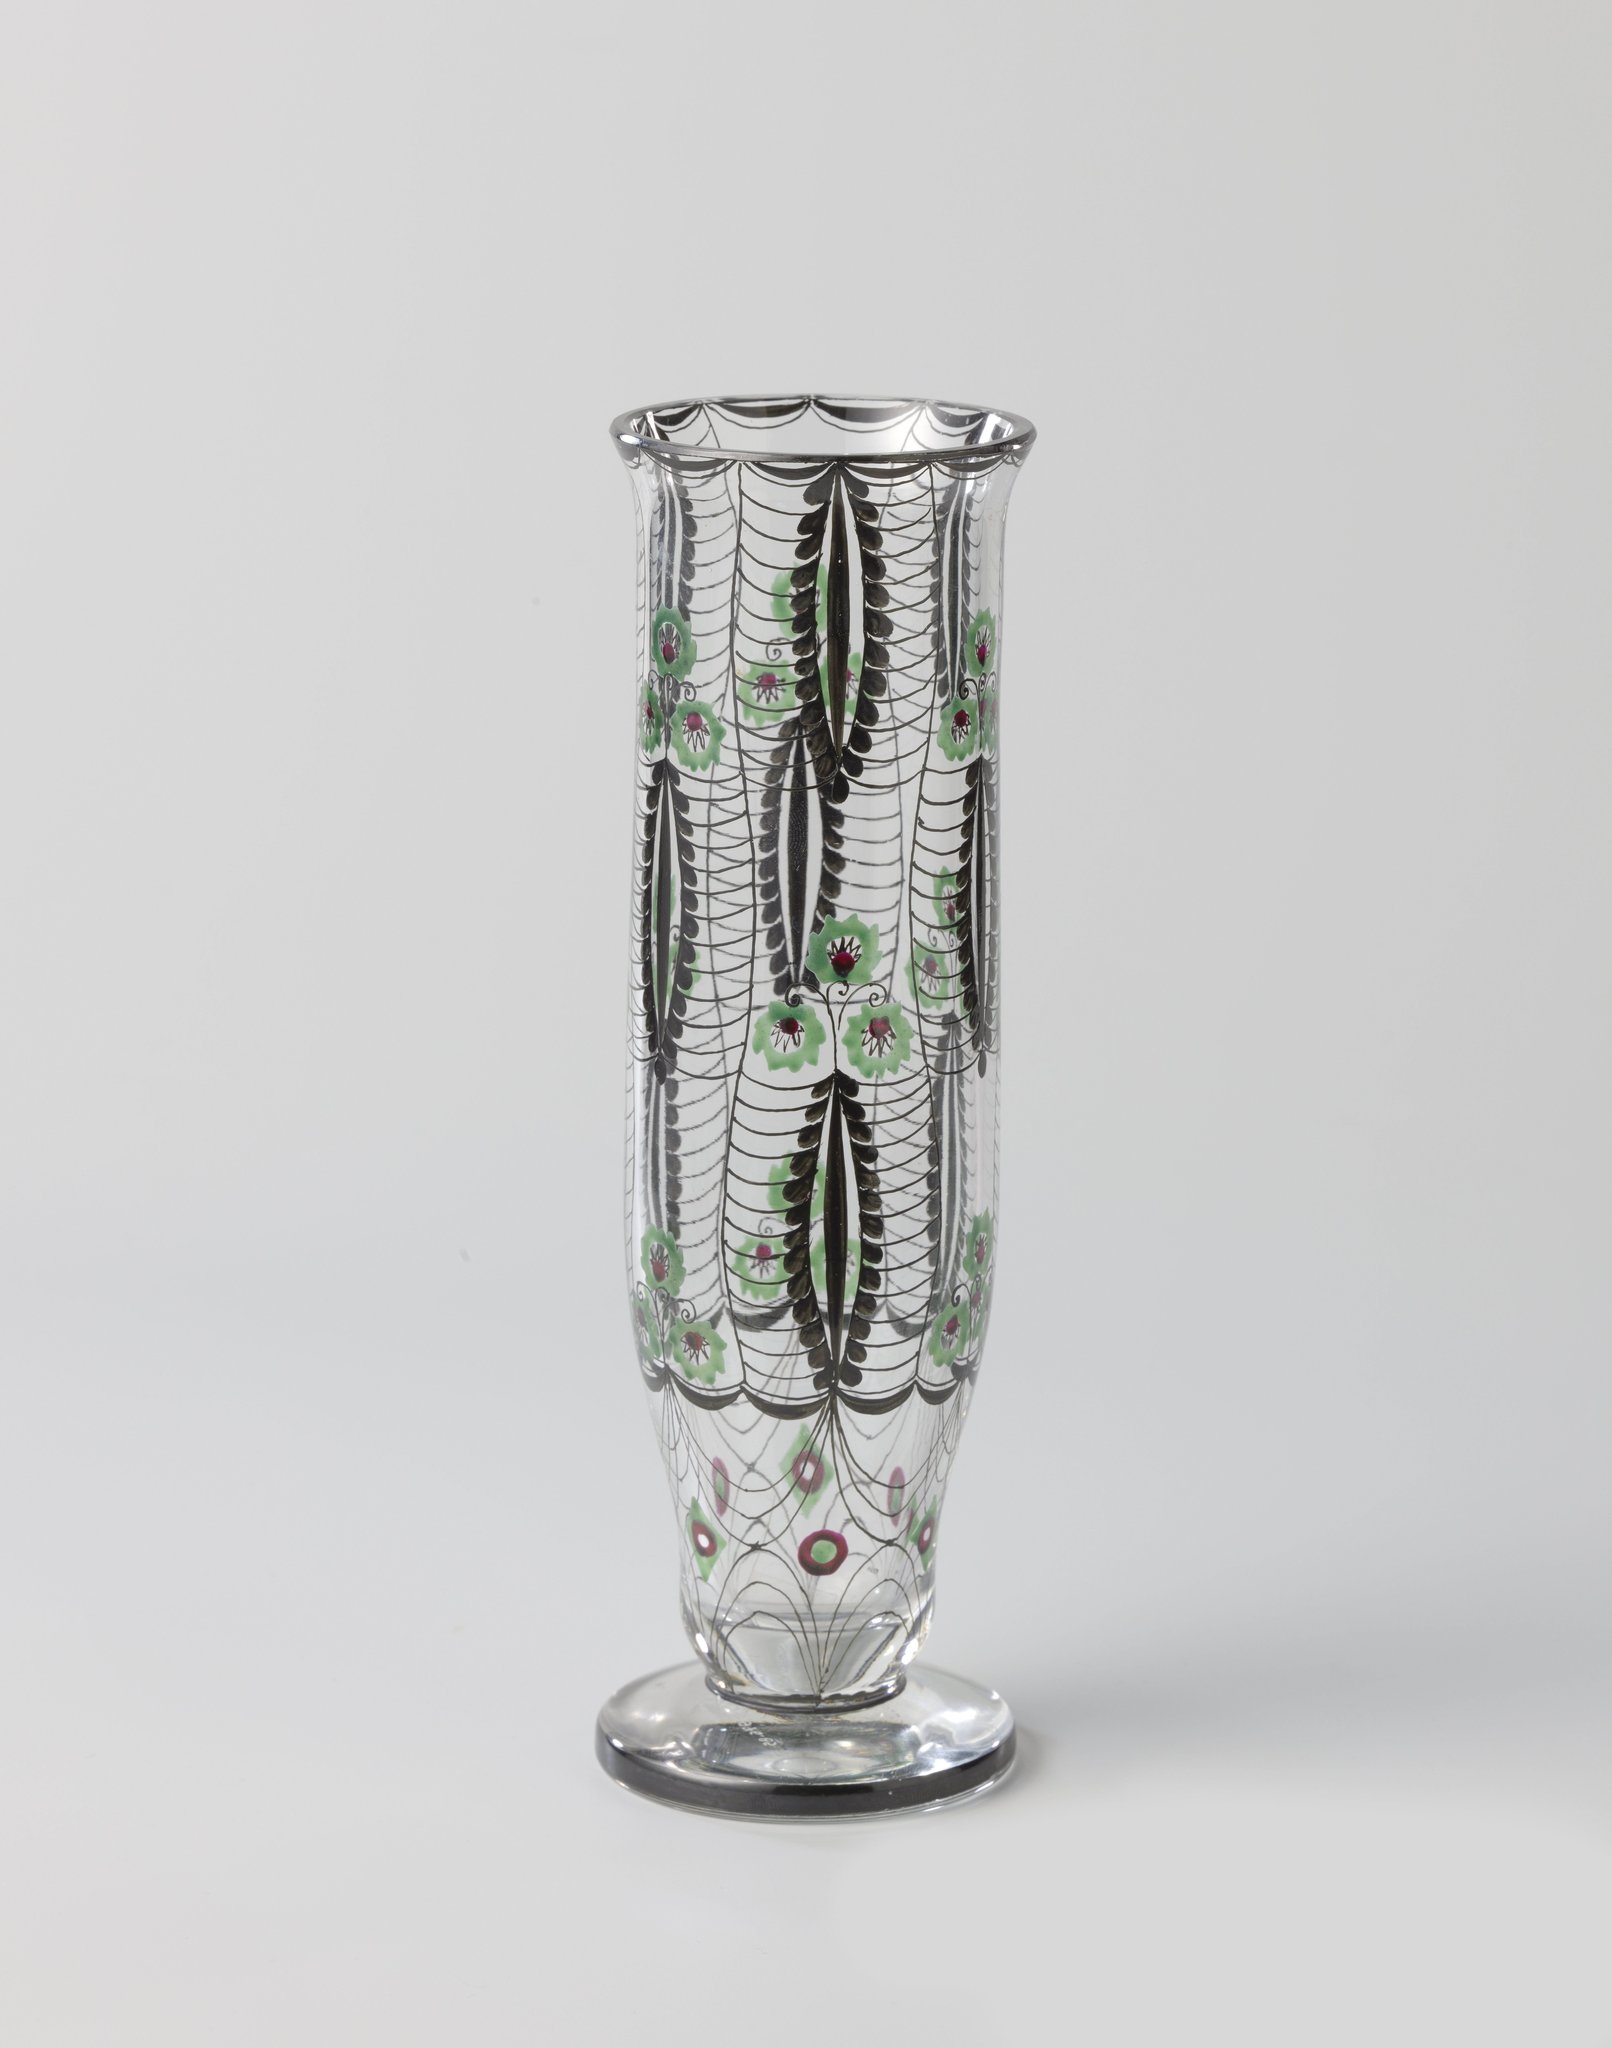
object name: vase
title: Vaas met bloemen in een spinragdecor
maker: Anonymous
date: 1916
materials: glass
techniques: glassblowing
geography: haida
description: Platte voet, gebogen lichaam, beschilderd met bloemen in een spinragdecor in rood, groen en zwart.